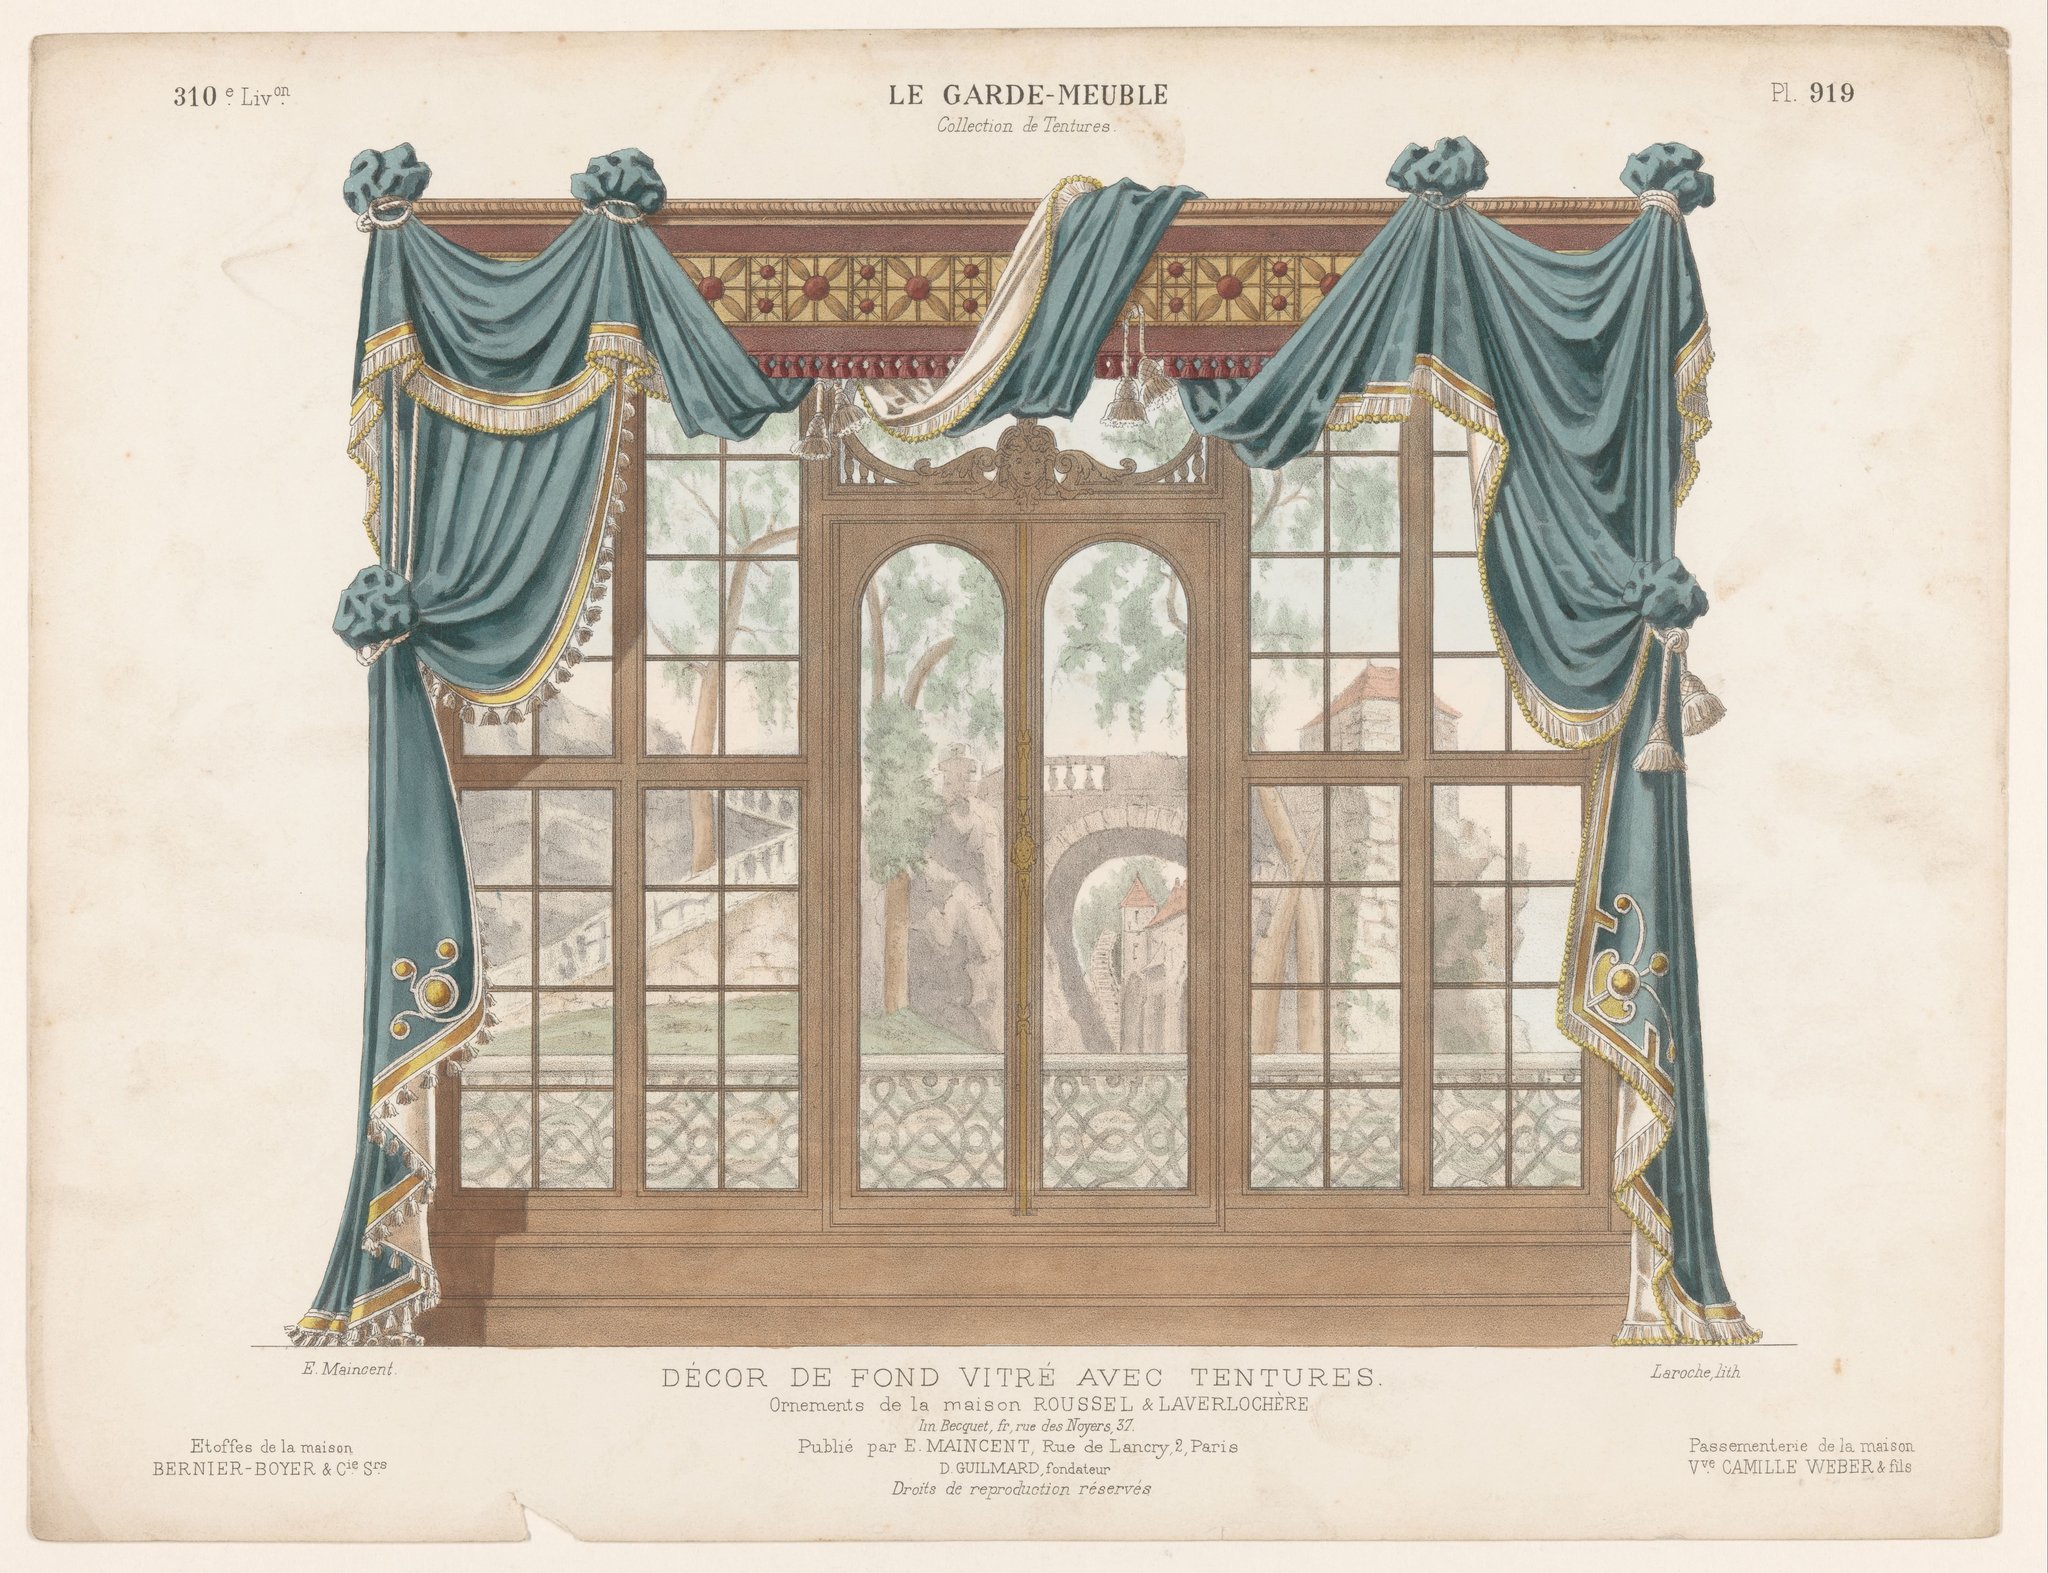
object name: print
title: Le Garde-Meuble / Collection de Tentures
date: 1885-1895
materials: paper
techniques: hand coloring, lithograph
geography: paris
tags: window, hangings and drapery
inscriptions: : ‘Droits de reproduction réservés.’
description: Raampartij met gedrapeerde gordijnen en uitzicht op een kasteel. Prent uit 310e Livraison.